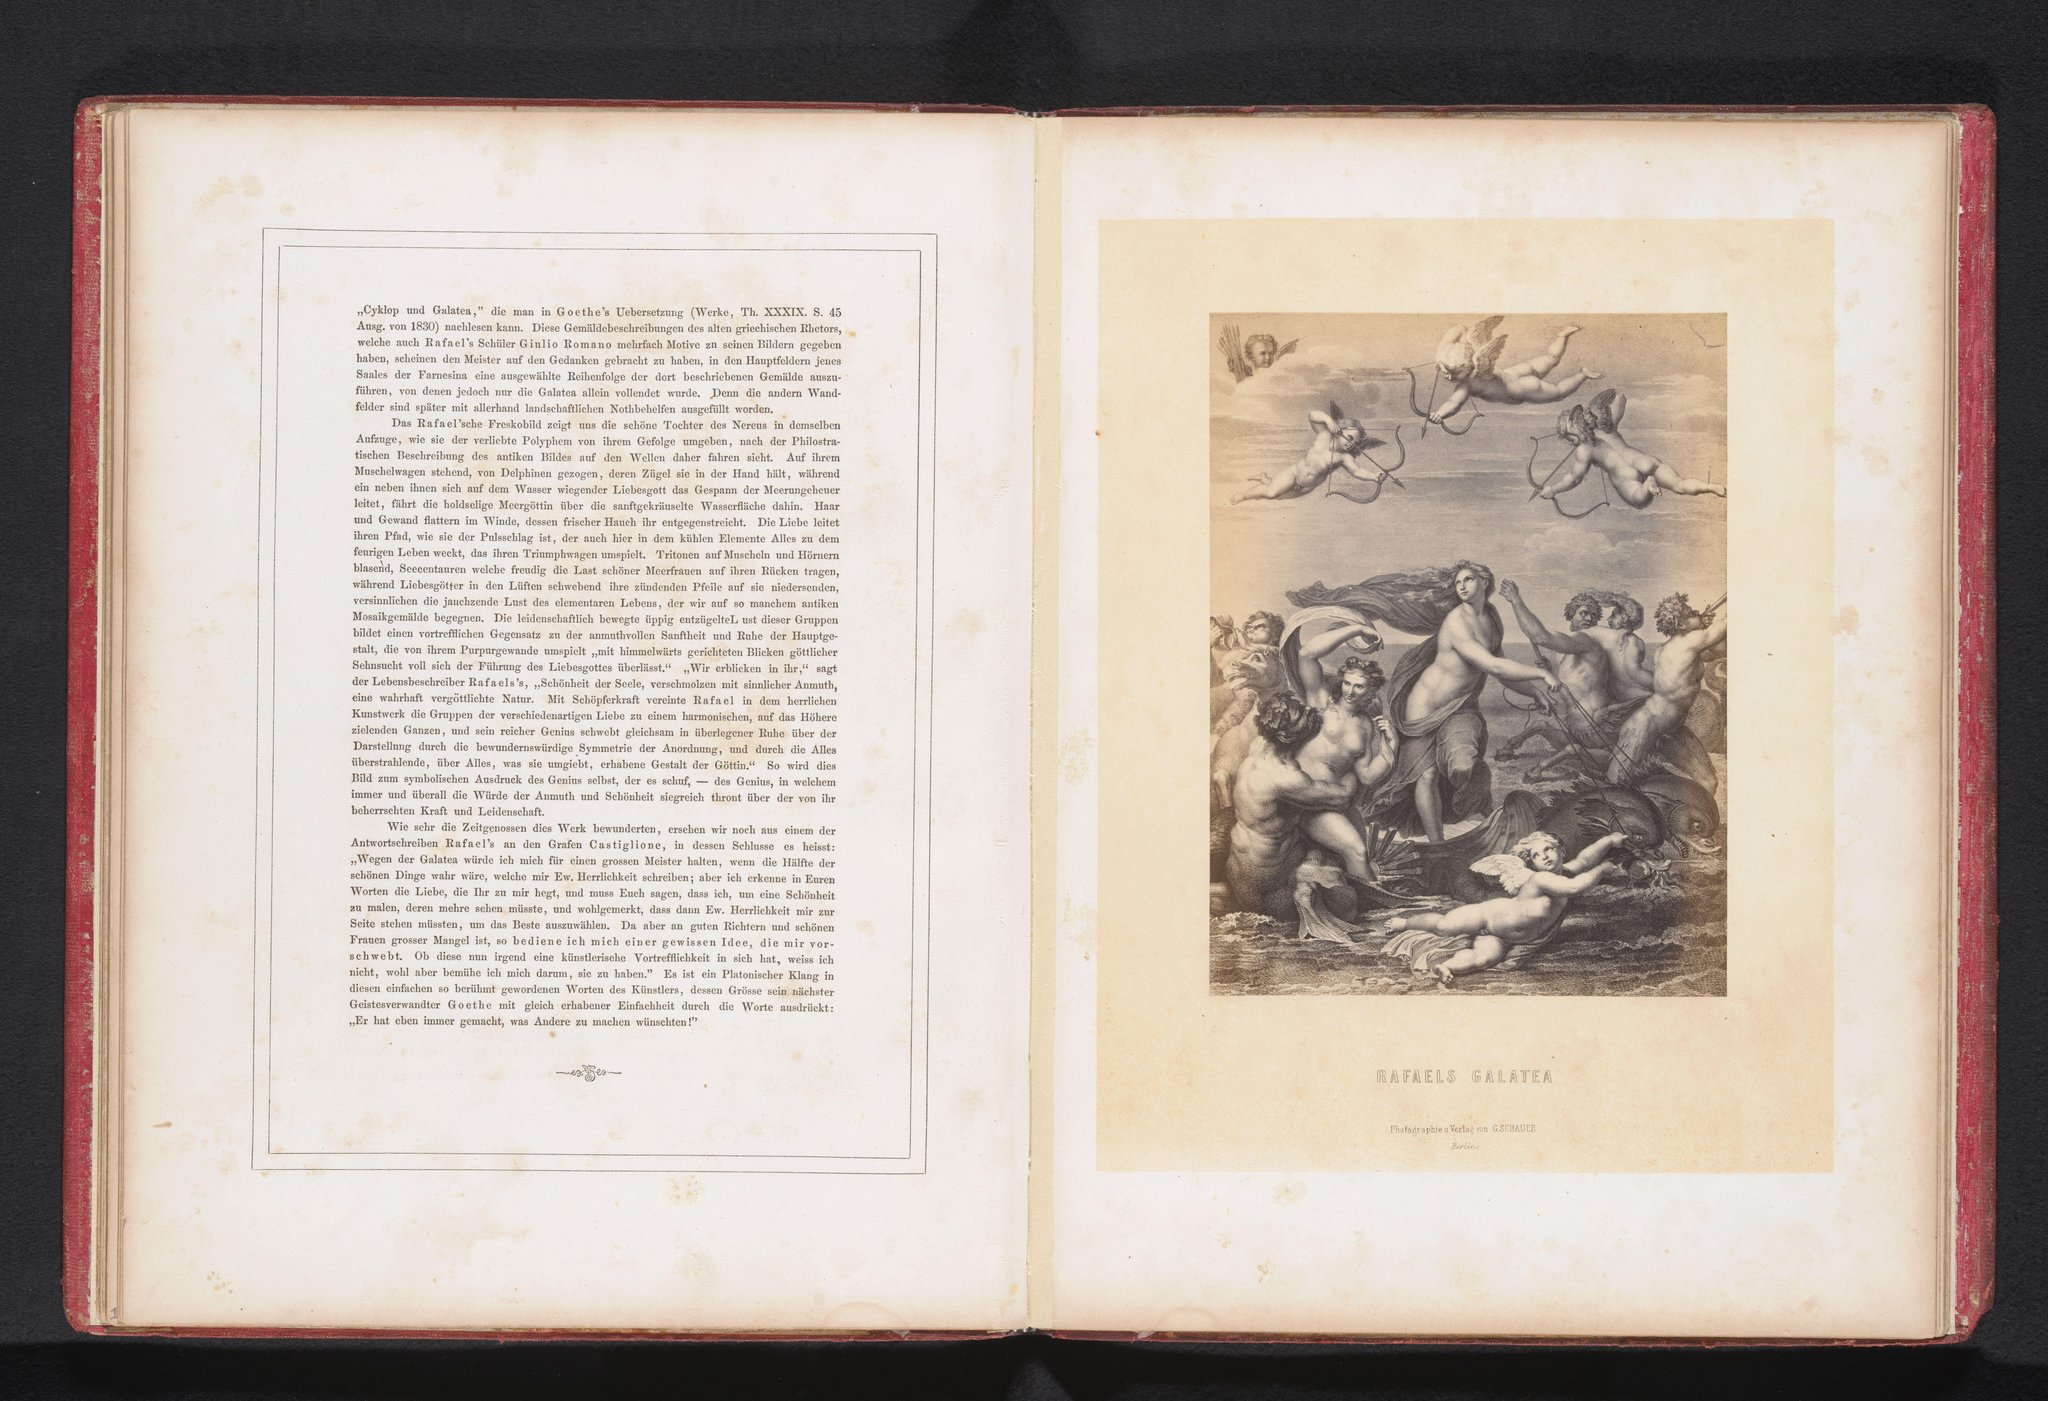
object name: reproduction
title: Rafaels Galatea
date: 1851-1861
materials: photographic support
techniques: albumen print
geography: berlin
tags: triumph of galatea